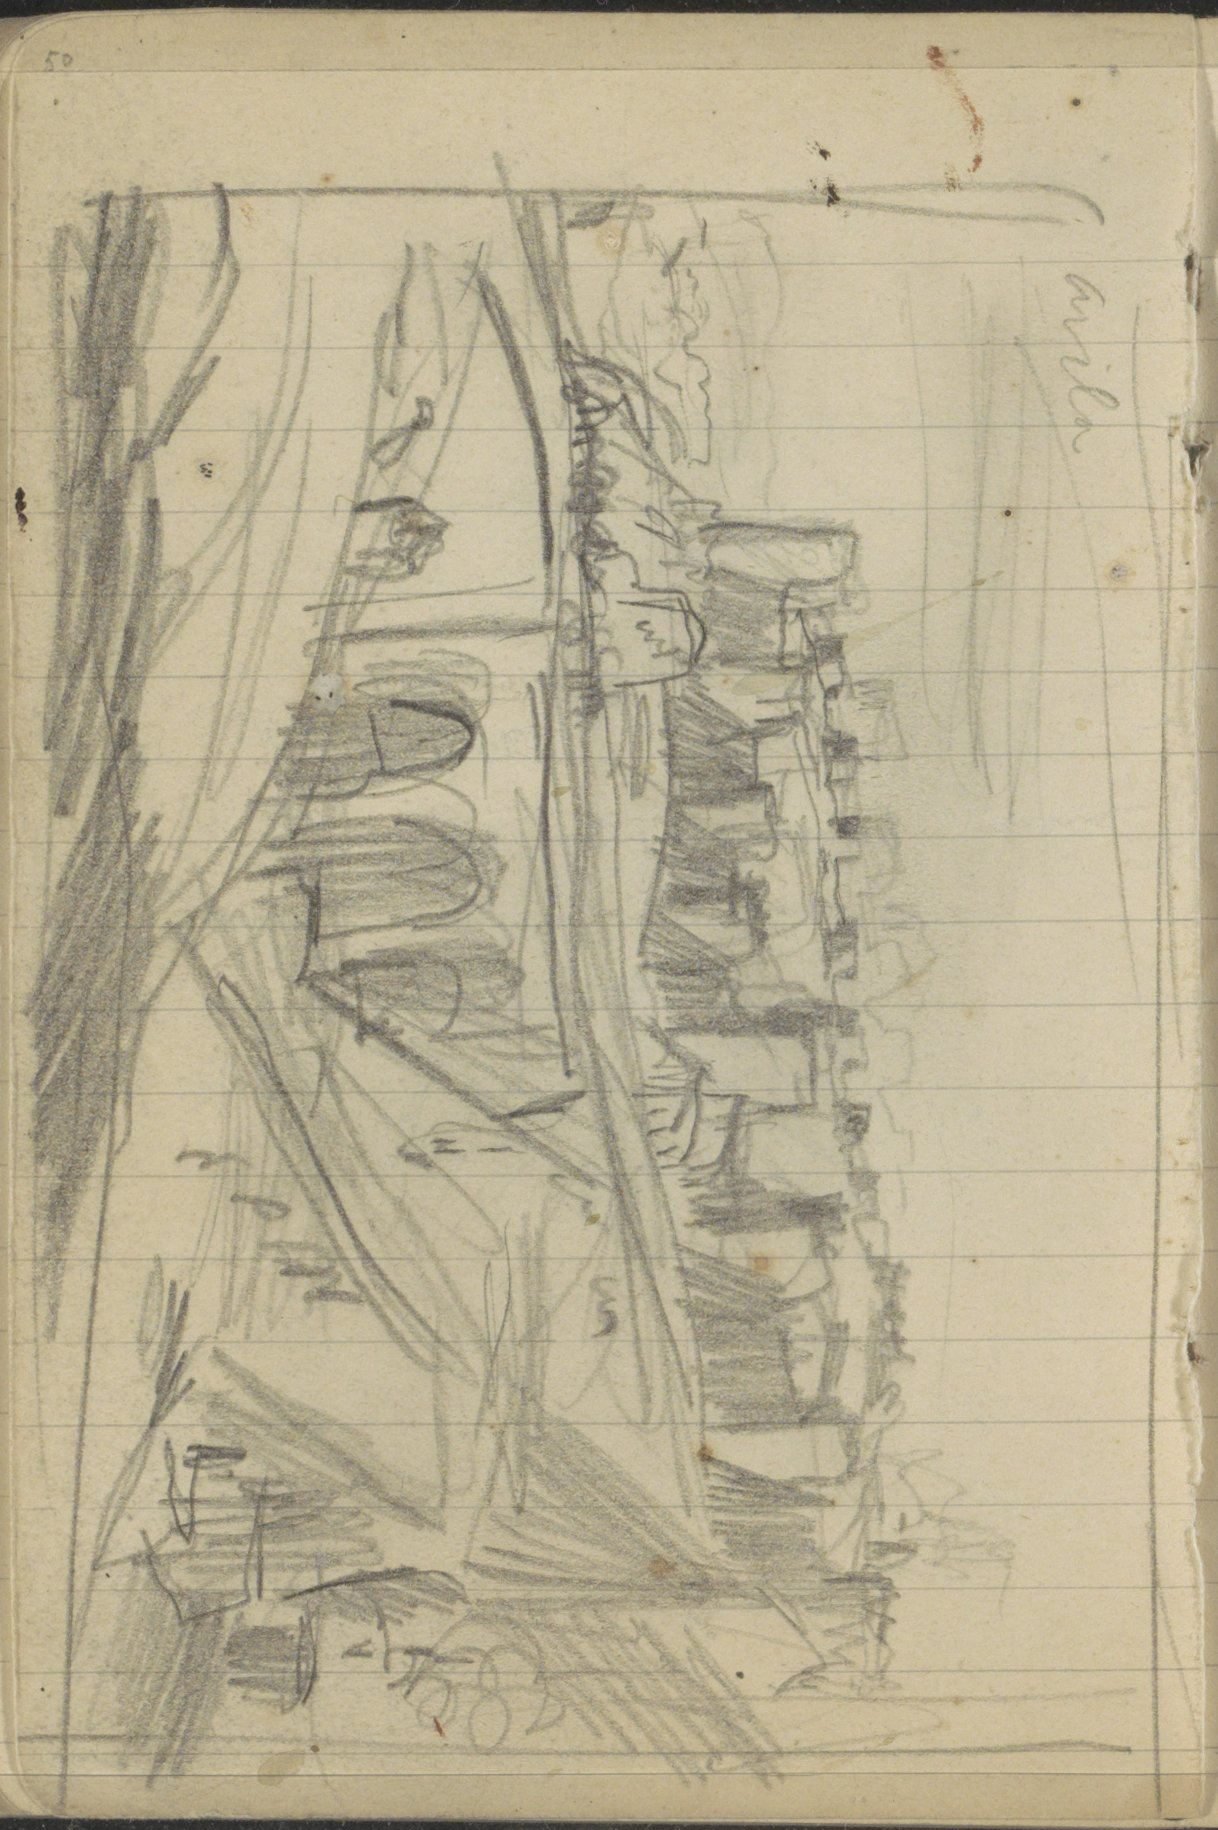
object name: sketchbook leaf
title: Gezicht op Ávila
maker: marius bauer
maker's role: draughtsman, print maker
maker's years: 1867-1932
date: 1902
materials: pencil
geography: avila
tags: city-view, and landscape with man-made constructions, bridge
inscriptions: annotation: ‘avila’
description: Met op de voorgrond de brug richting de stad. Pagina 50 uit een schetsboek met 50 bladen.